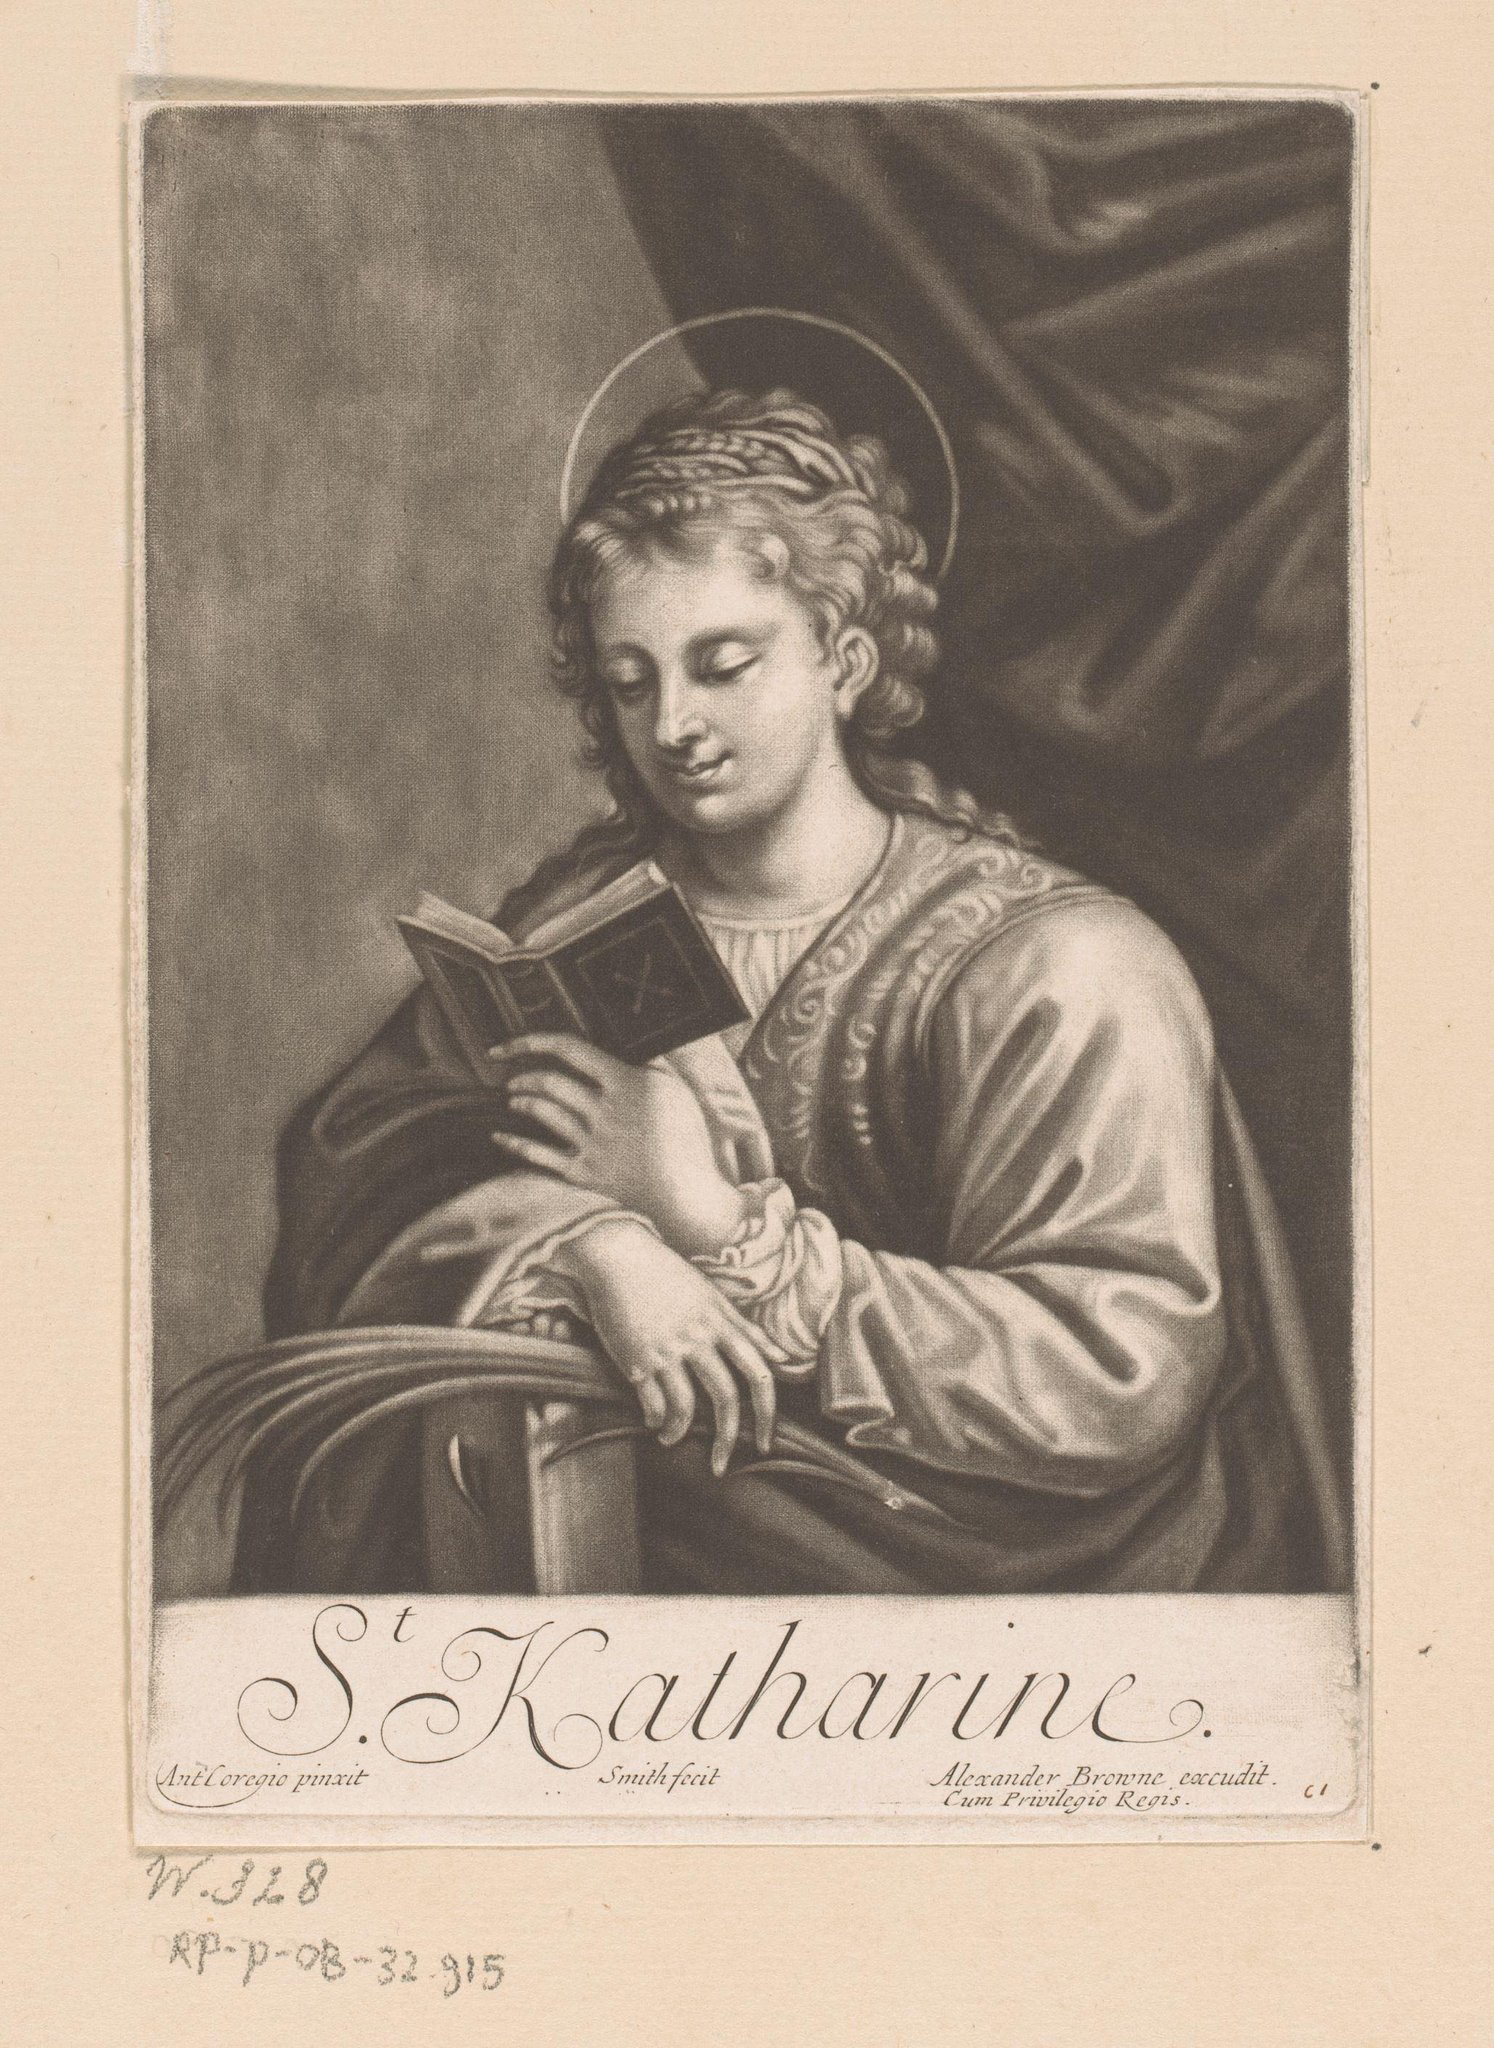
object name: print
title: H. Catharina van Alexandrië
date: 1669-1706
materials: paper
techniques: mezzotint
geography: england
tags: the virgin martyr catherine of alexandria; possible attributes: book, crown, emperor maxentius, palm-branch, ring, sword, wheel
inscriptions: collector's mark: Lugt 240